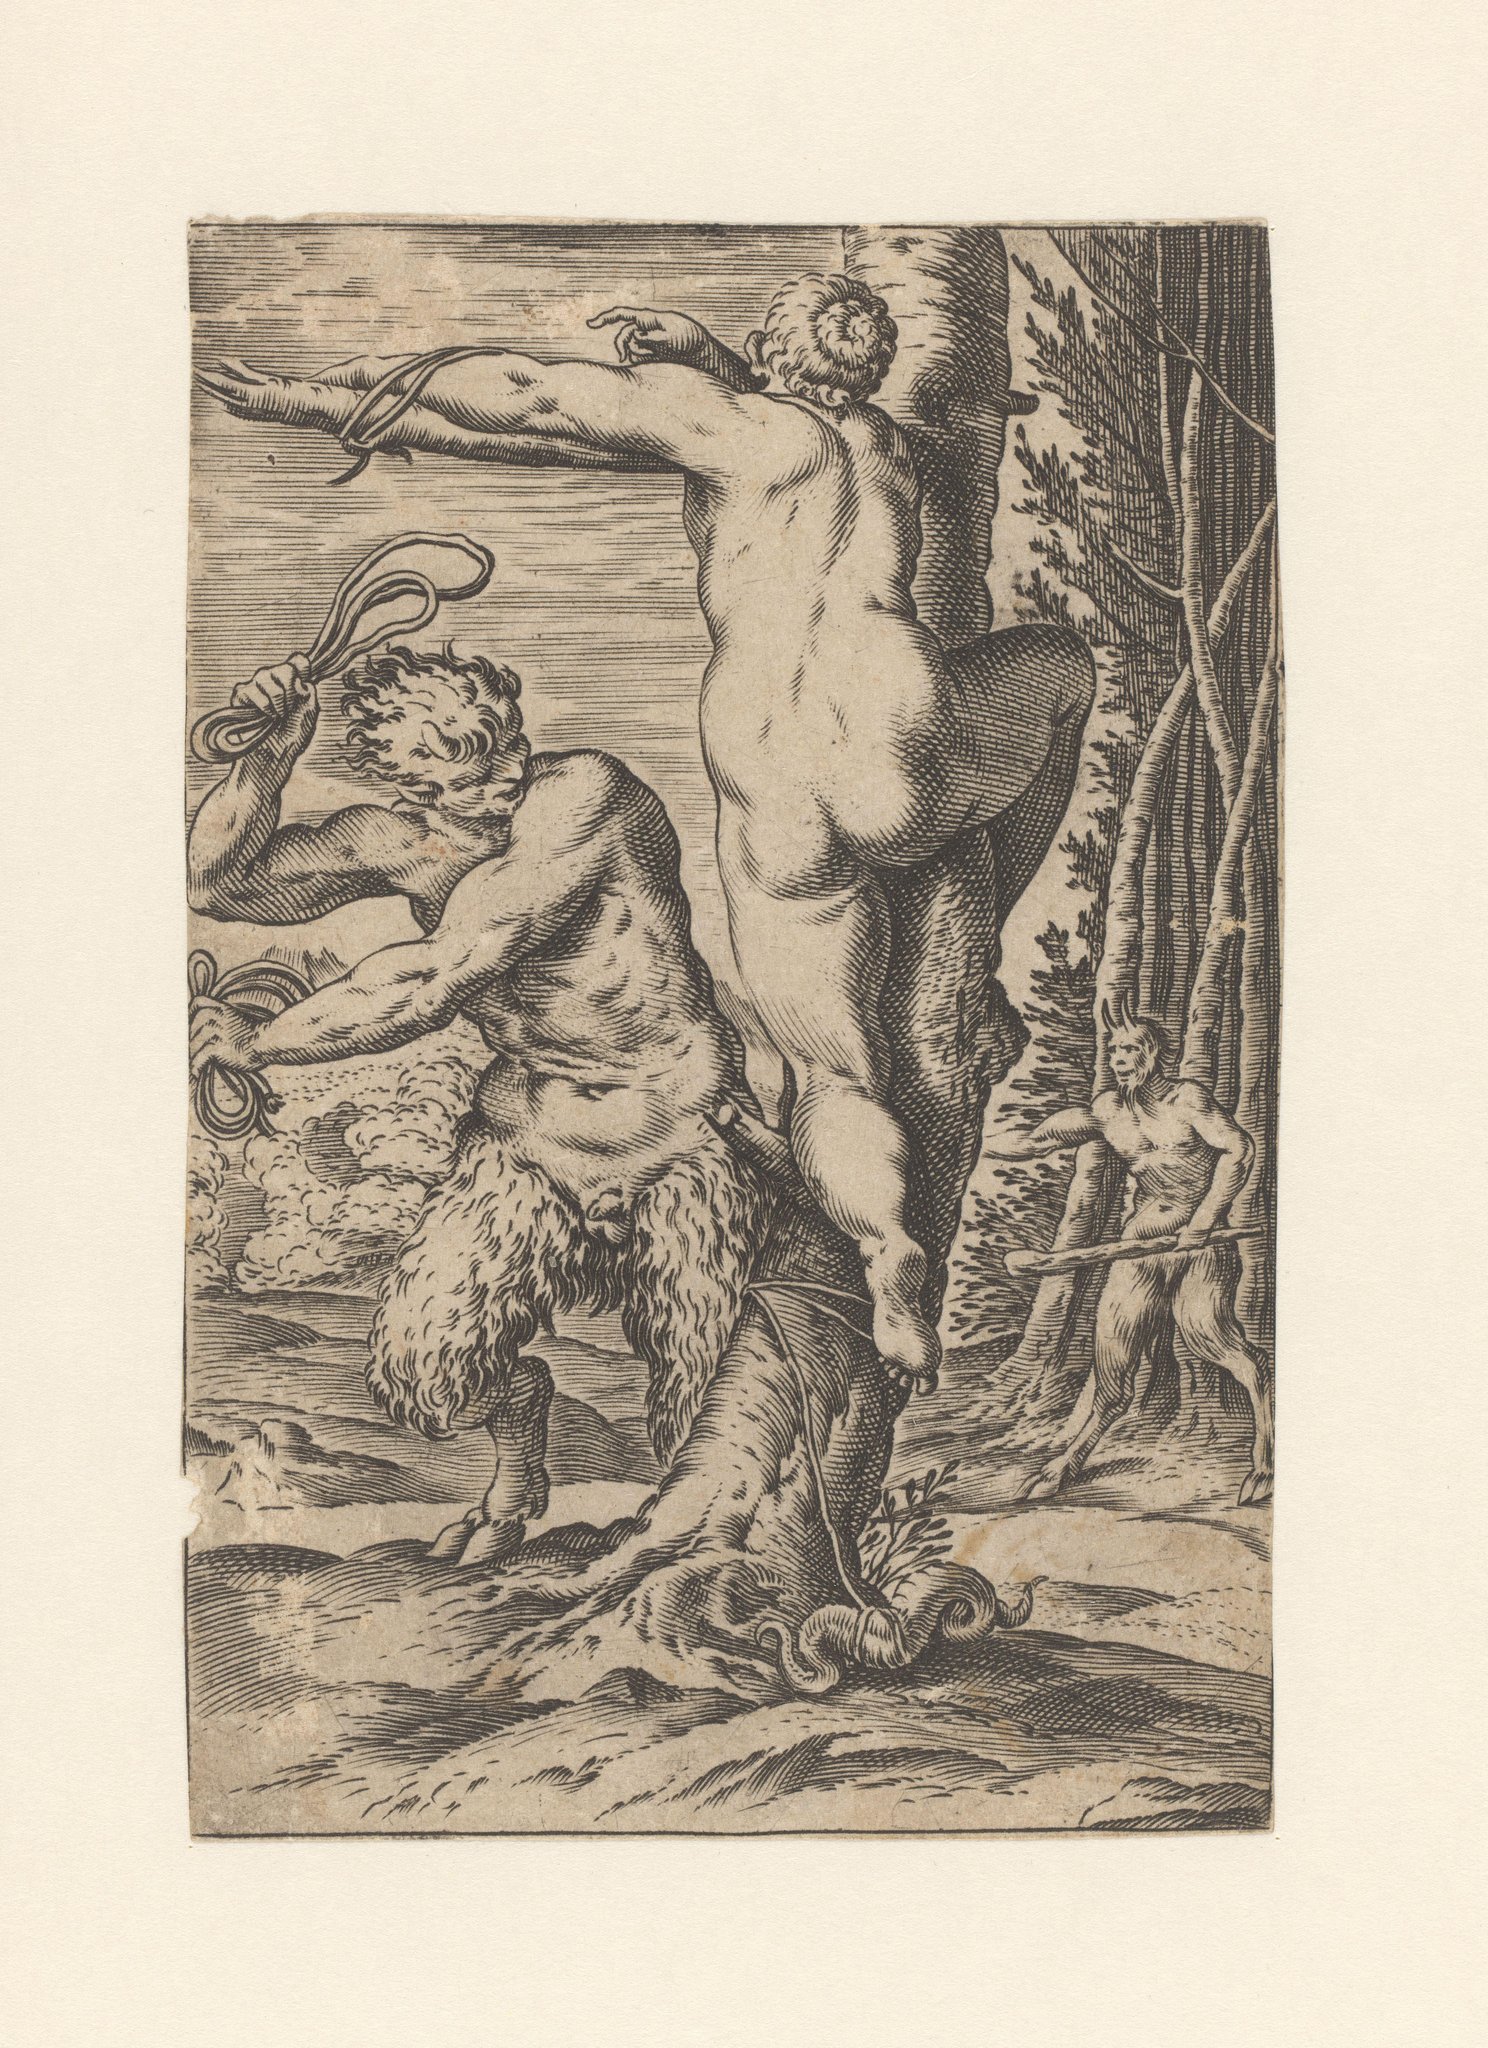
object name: print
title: Sater slaat nimf met een zweep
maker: agostino carracci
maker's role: draughtsman, painter, print maker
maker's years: 1557-1602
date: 1590-1595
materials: paper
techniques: engraving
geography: italy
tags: nymphs (in general); 'ninfe in commune' (ripa), satyr(s) (in general), whip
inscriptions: collector's mark: Lugt 240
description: Een naakte nimf zit vastgebonden aan een boomstam. Een sater slaat haar met een zweep. Op de achtergrond staat een sater met een knots bij de rand van het bos.